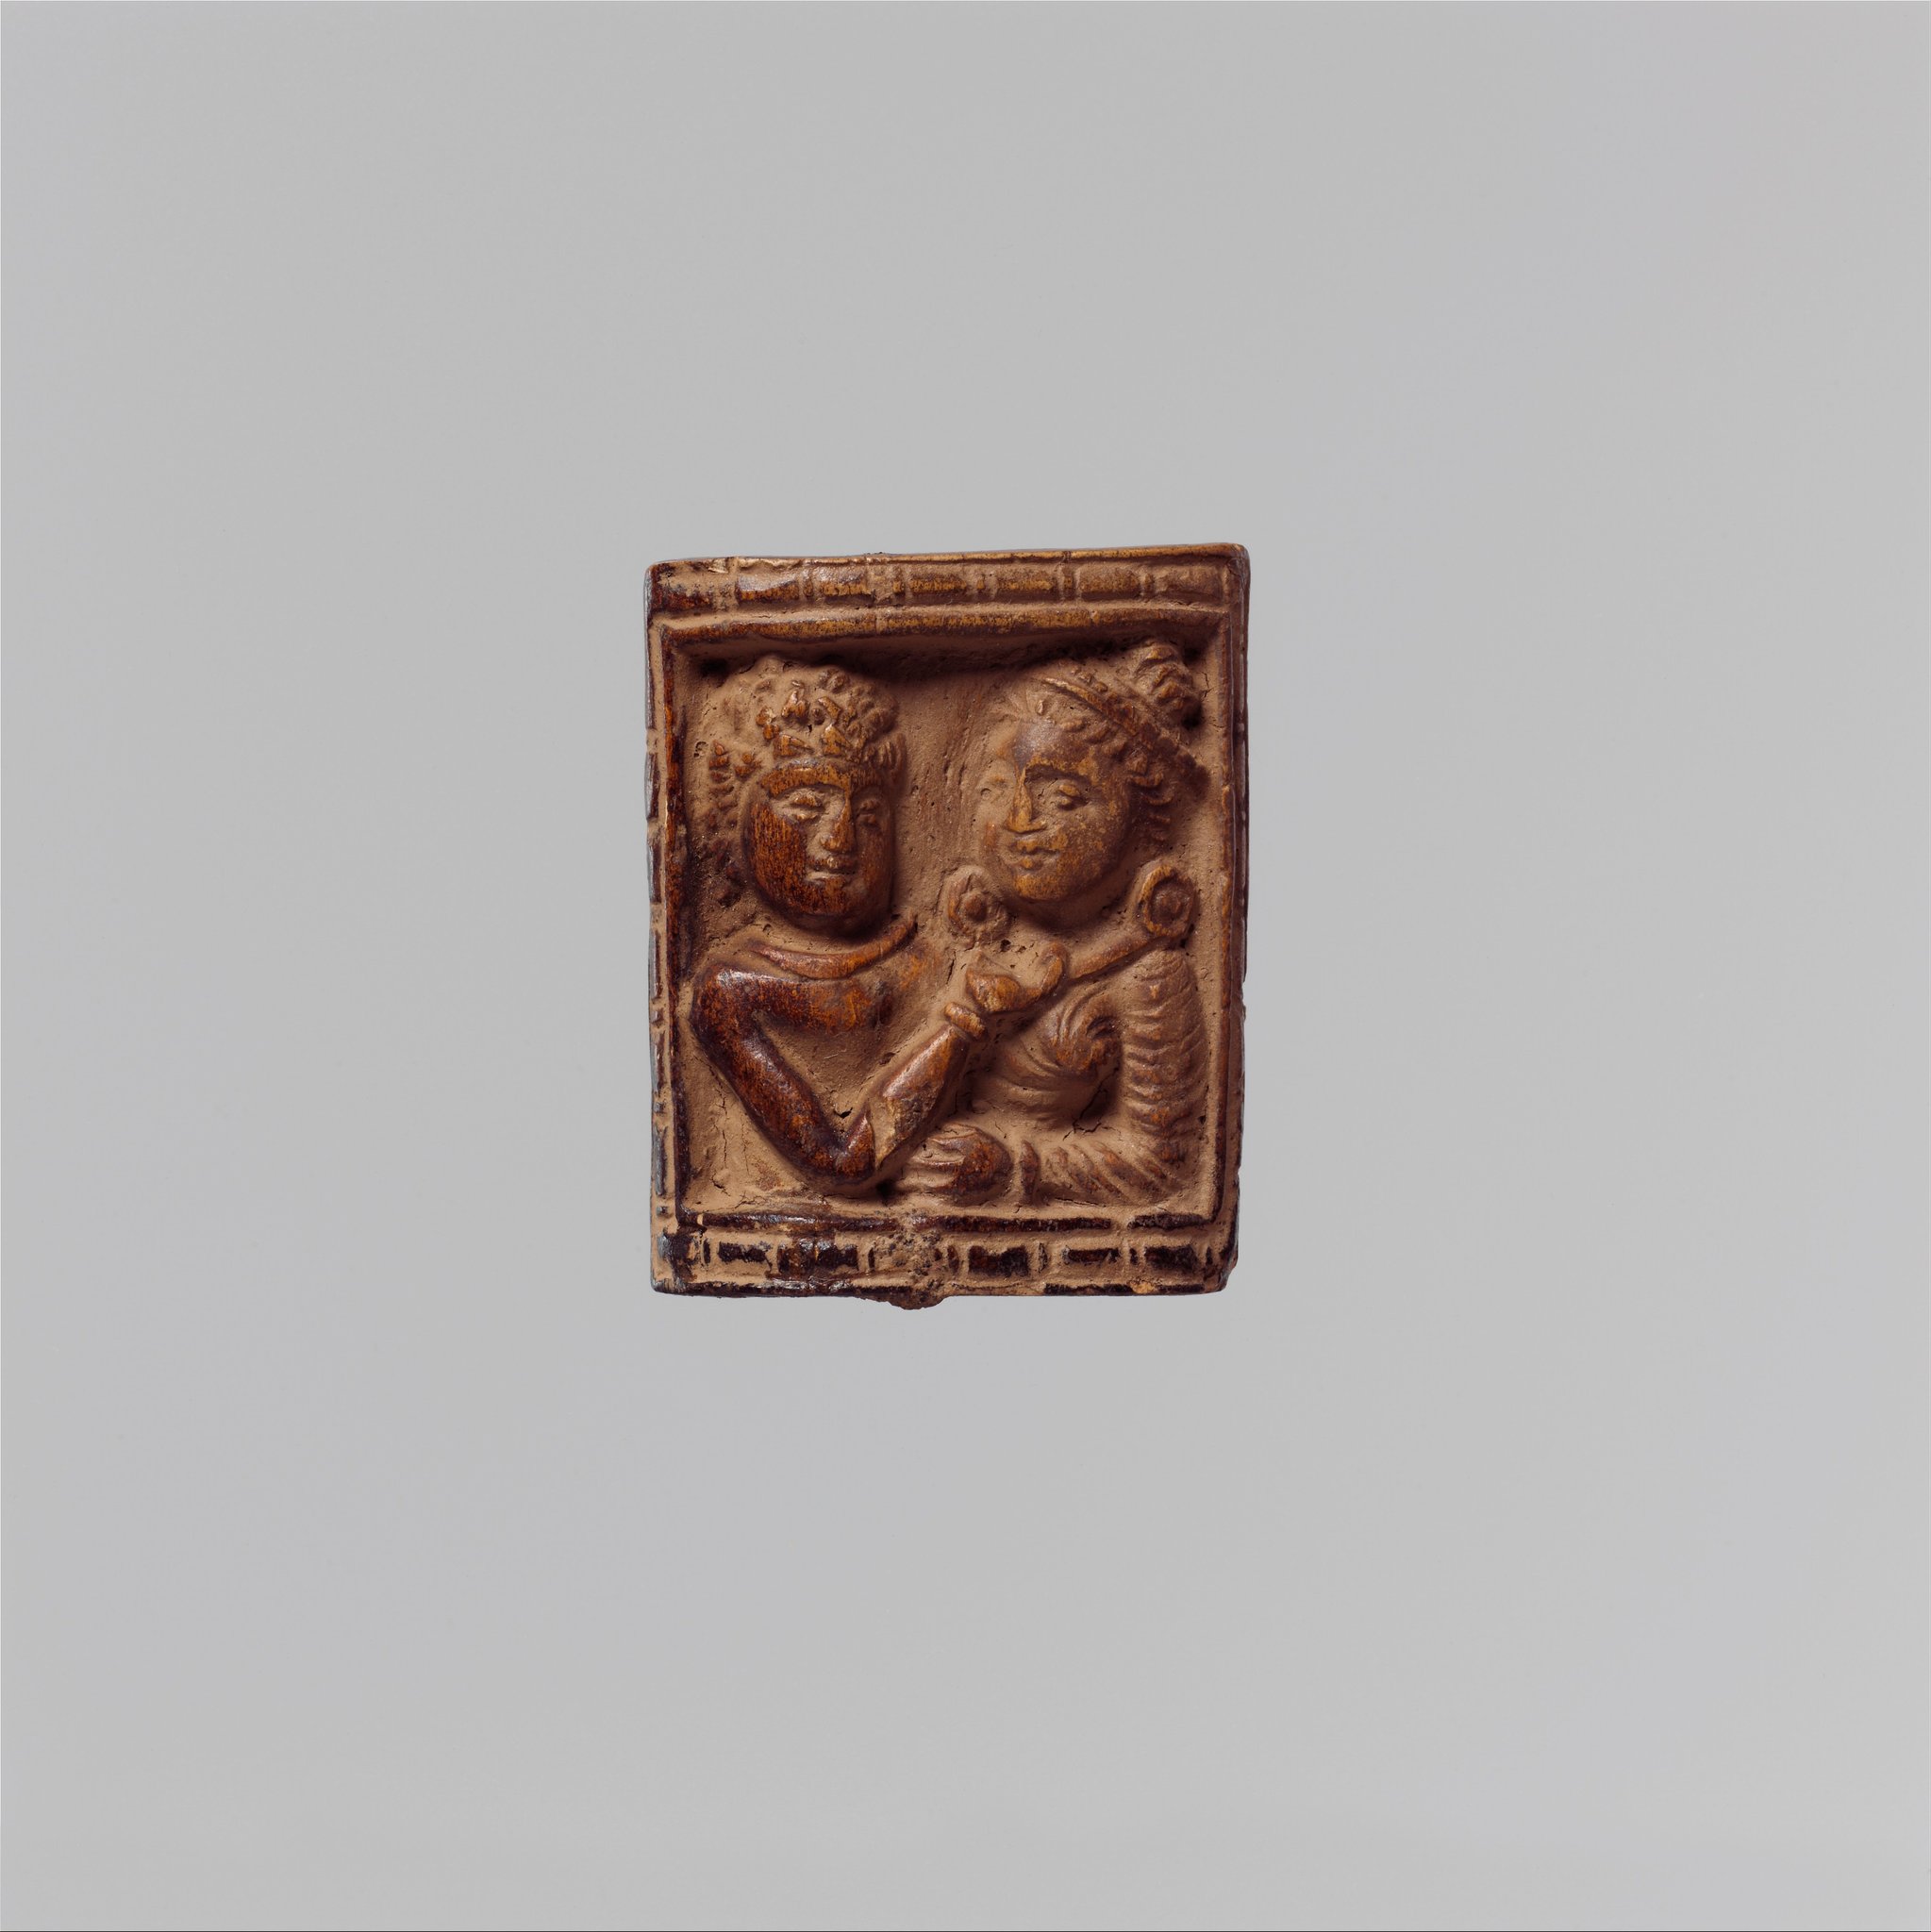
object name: plaque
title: Plaque with Loving Couple (Mithuna)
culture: afghan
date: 1-300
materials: bone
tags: satavahana,gandhara,couples,men,women